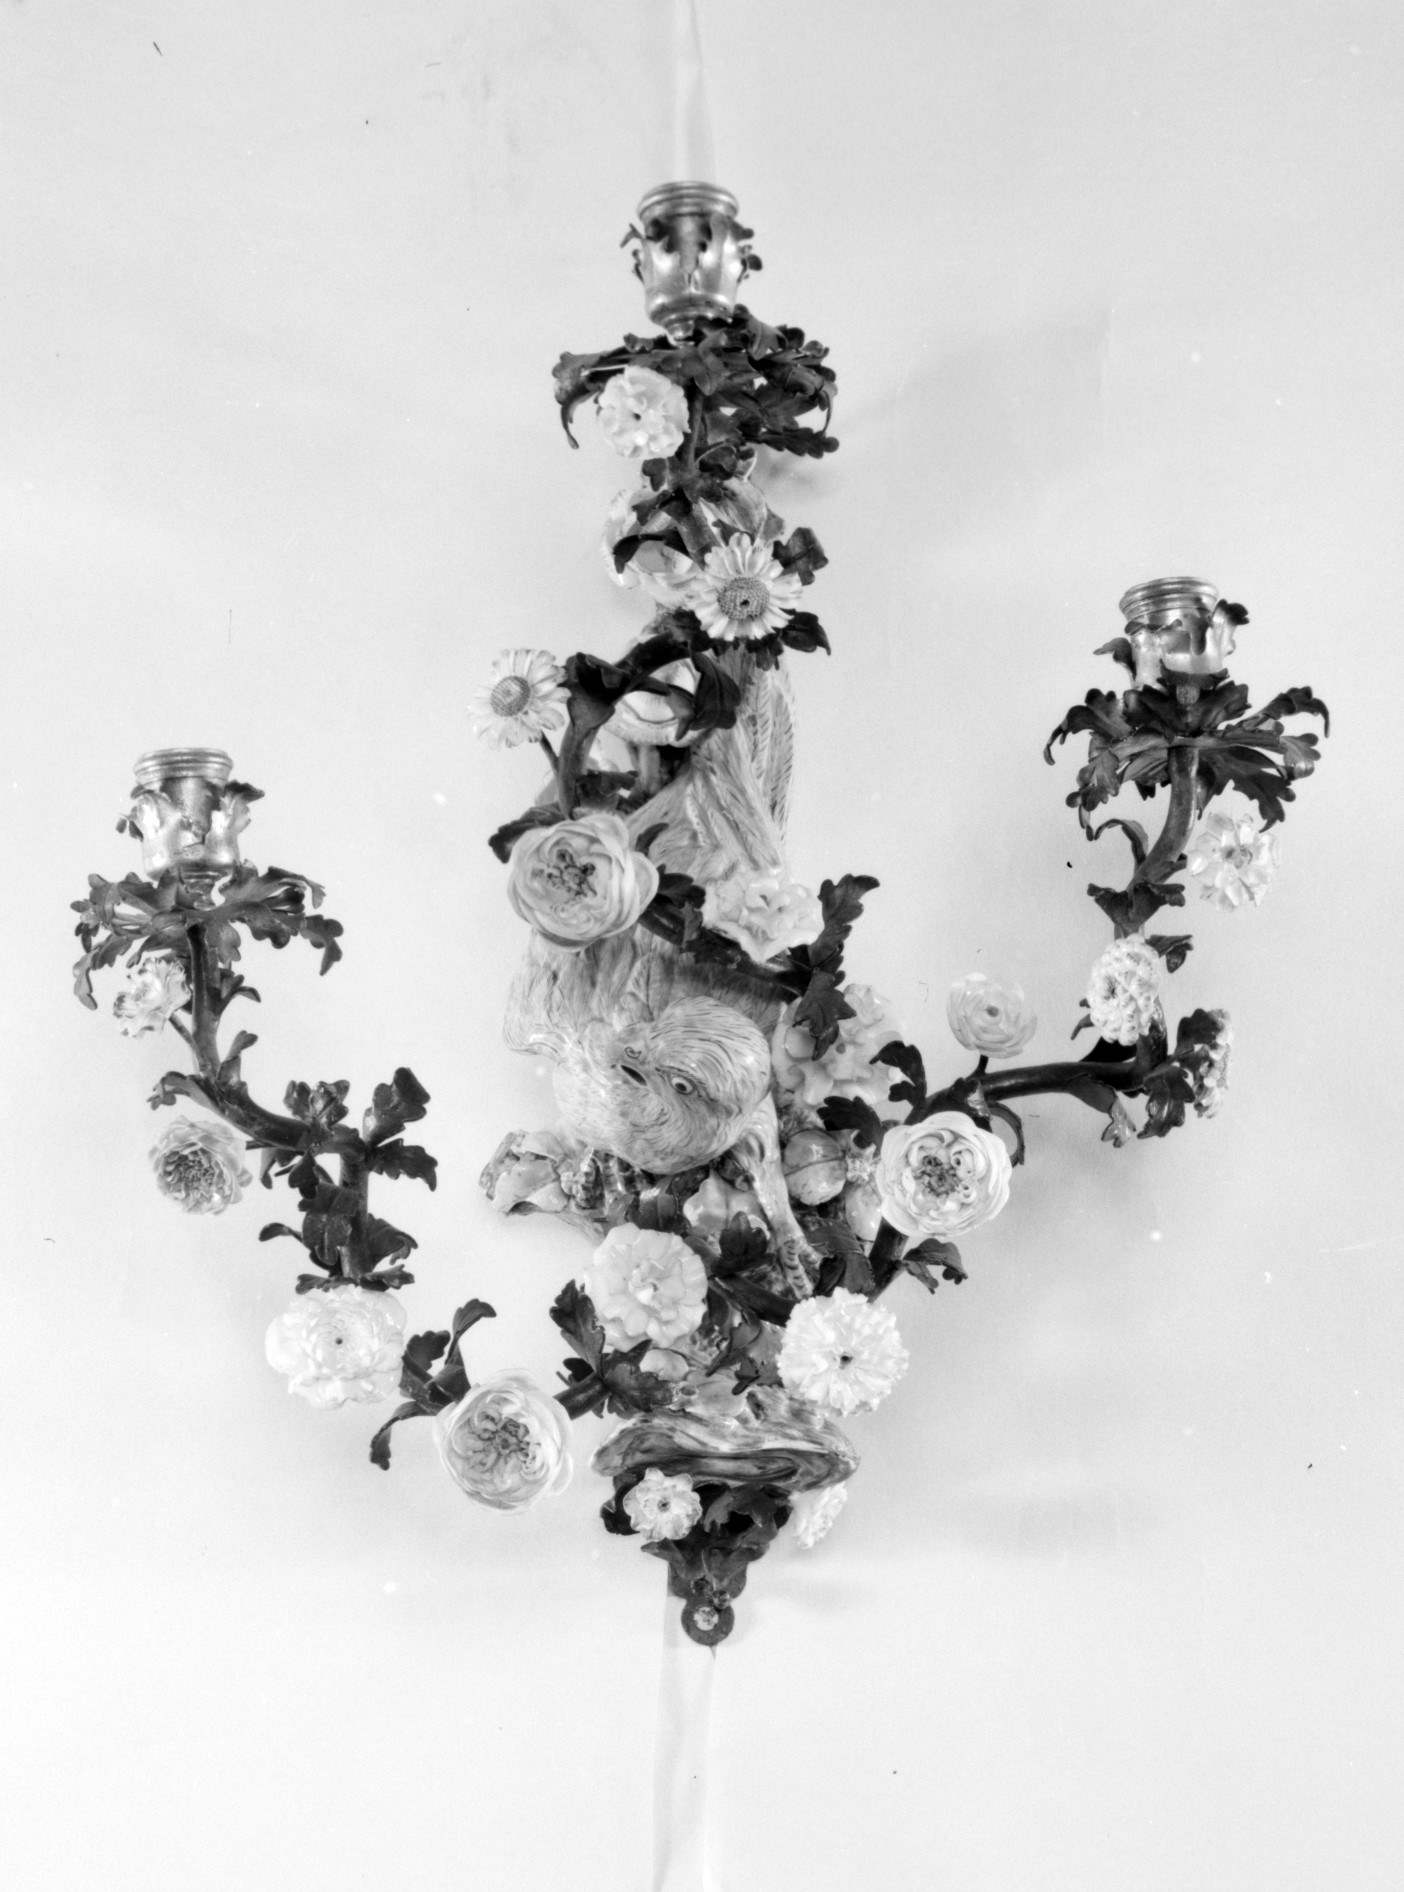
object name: wall light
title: Wall light (one of a pair)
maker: chantilly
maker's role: manufactory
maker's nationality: french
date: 1740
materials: gilt bronze, soft paste porcelain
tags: birds,flowers